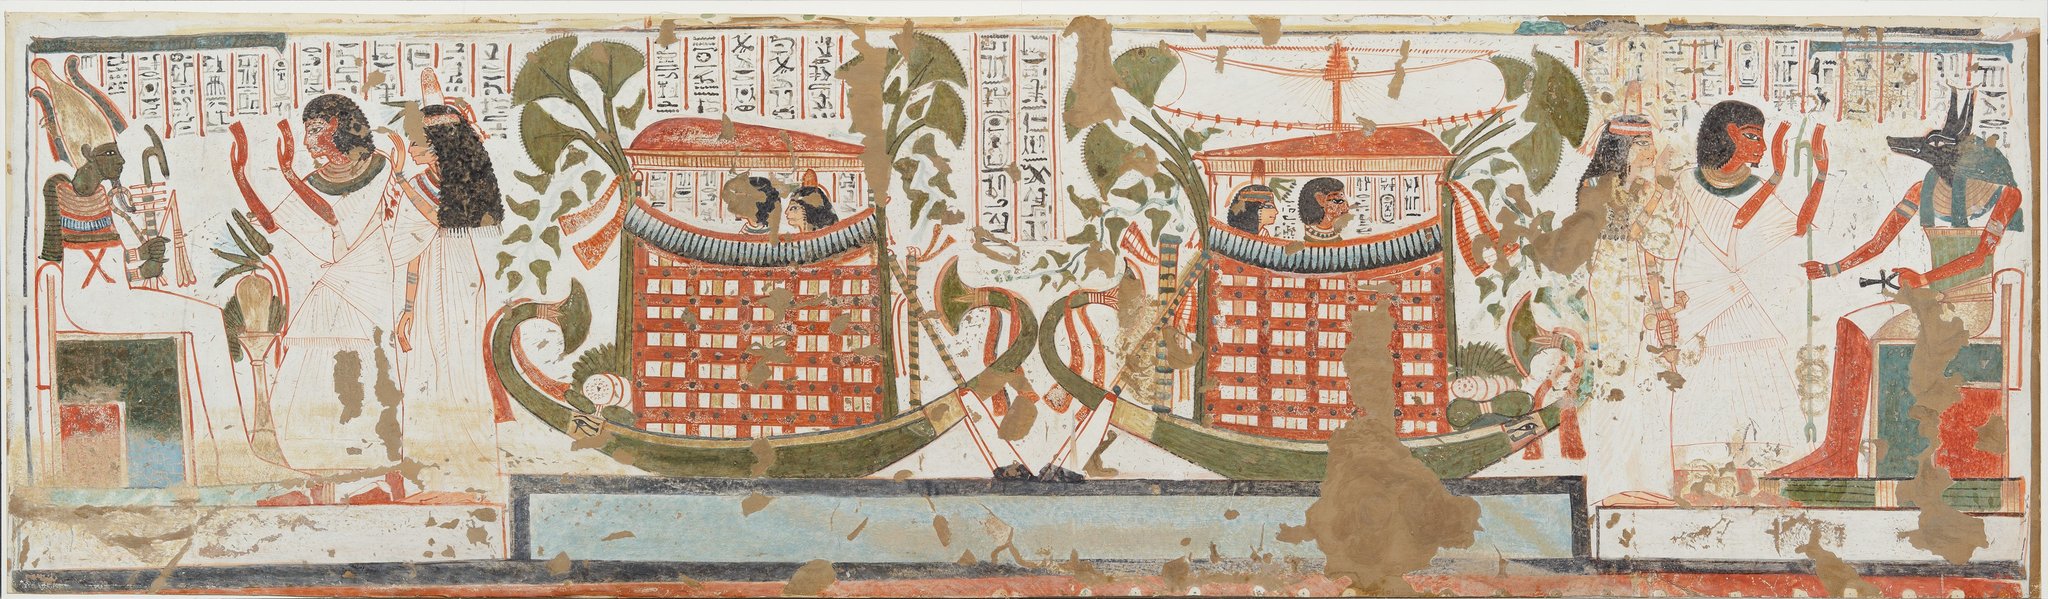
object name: facsimile, userhat tt 51, voyage to abydos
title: Userhat and Wife Visit Abydos, Tomb of Userhat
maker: norman de garis davies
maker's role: artist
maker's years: 1865-1941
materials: paper, paint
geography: egypt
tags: men,women,boats